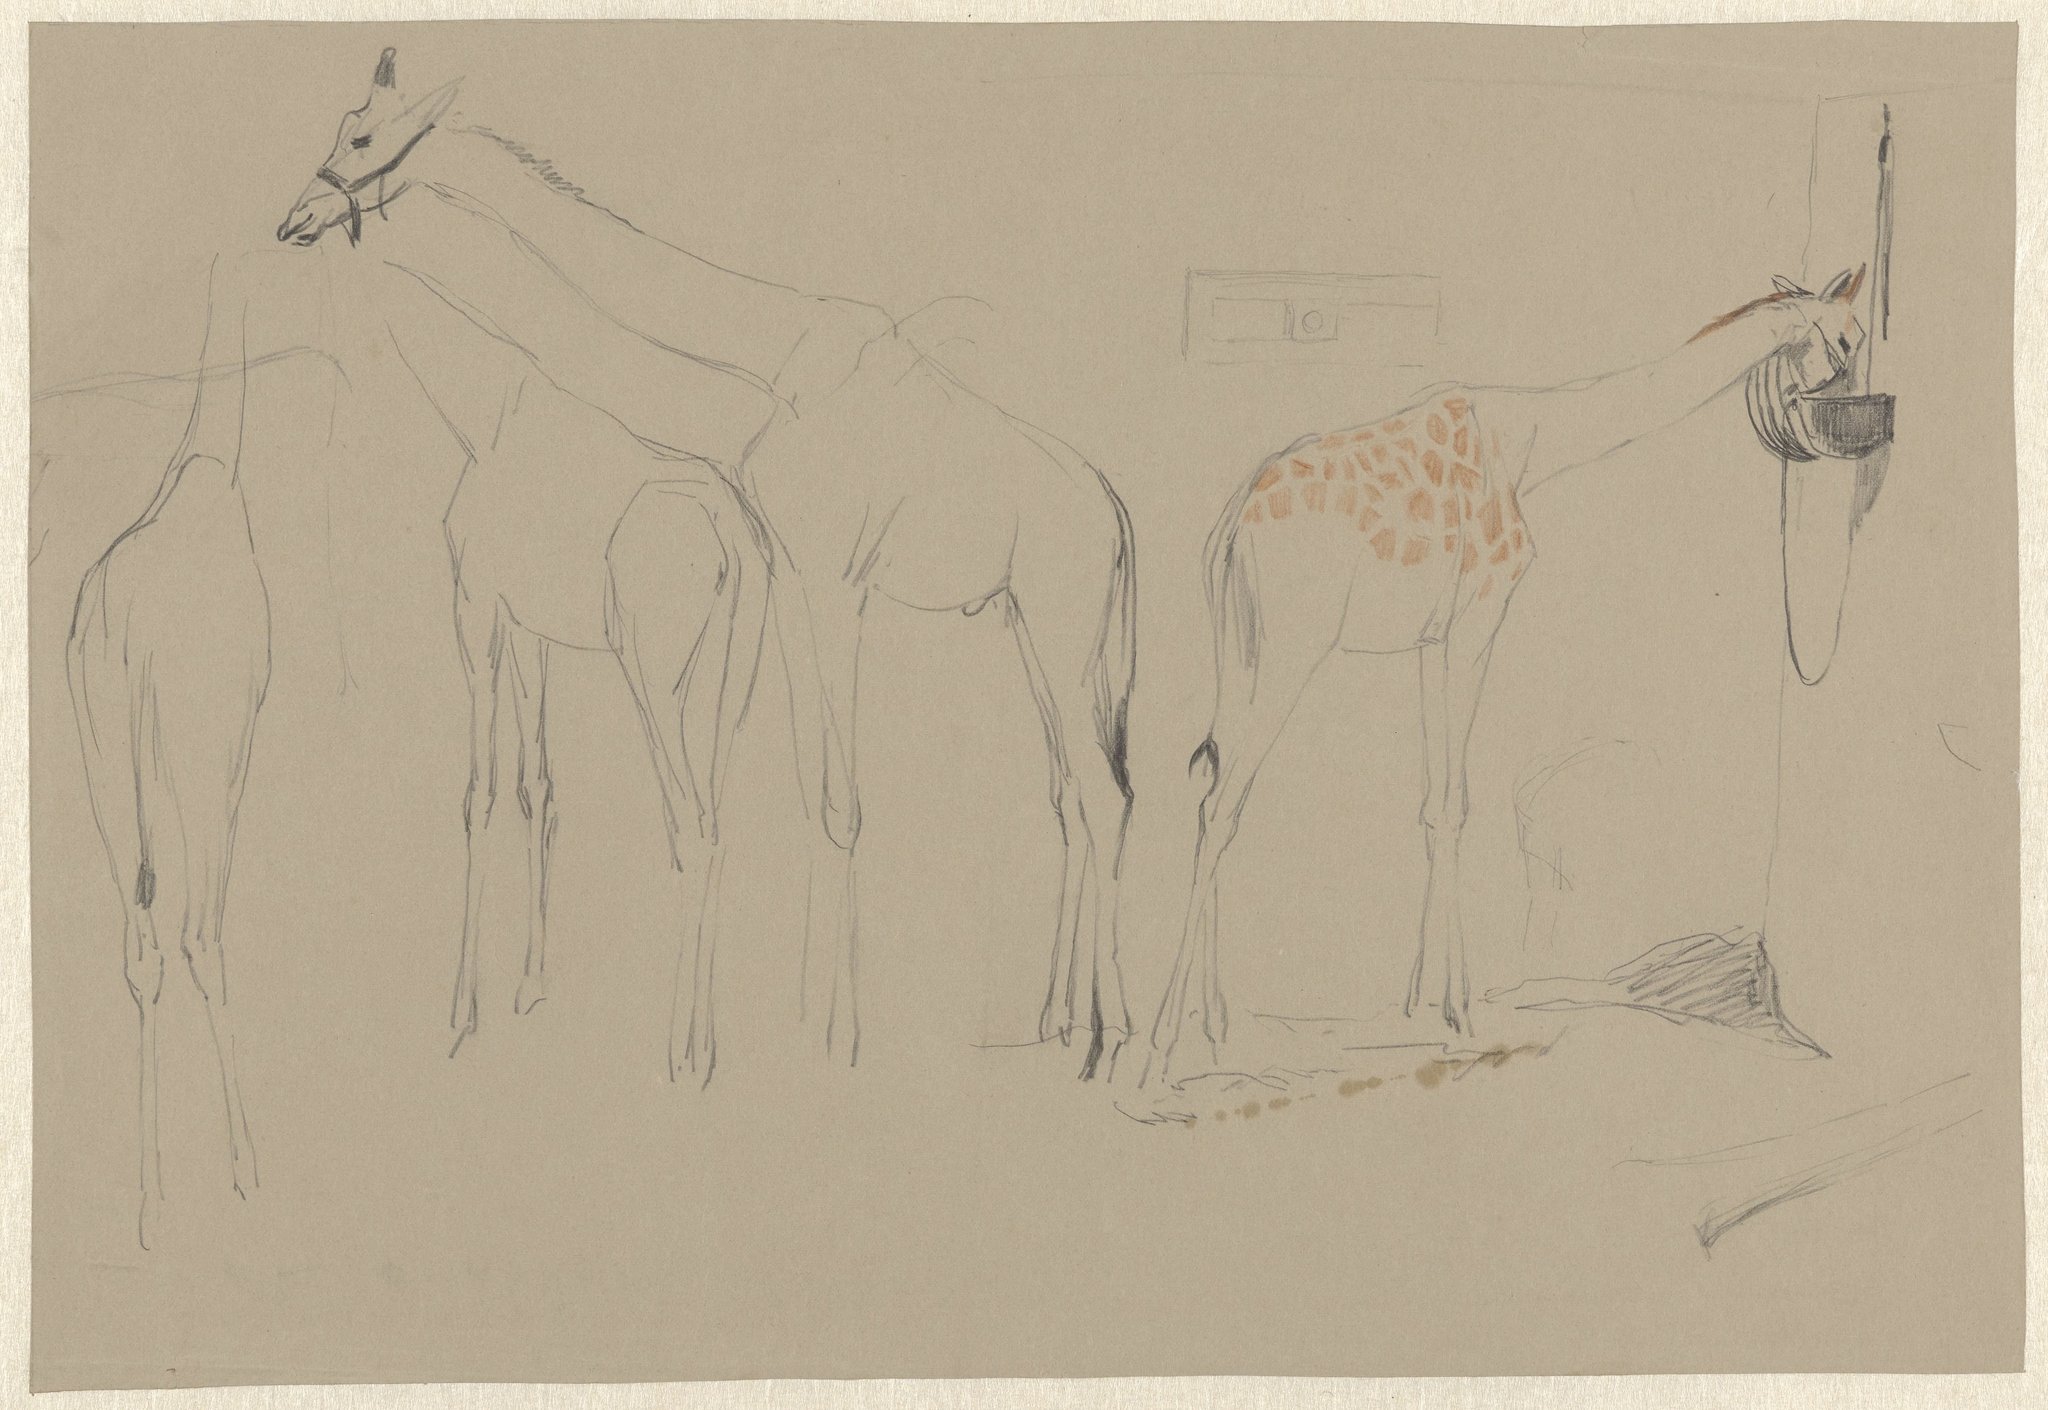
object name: drawing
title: Schetsblad met studies van giraffen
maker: guillaume anne van der brugghen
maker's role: draughtsman, print maker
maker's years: 1812-1891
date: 1821-1891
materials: chalk, paper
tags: hoofed animals: giraffe